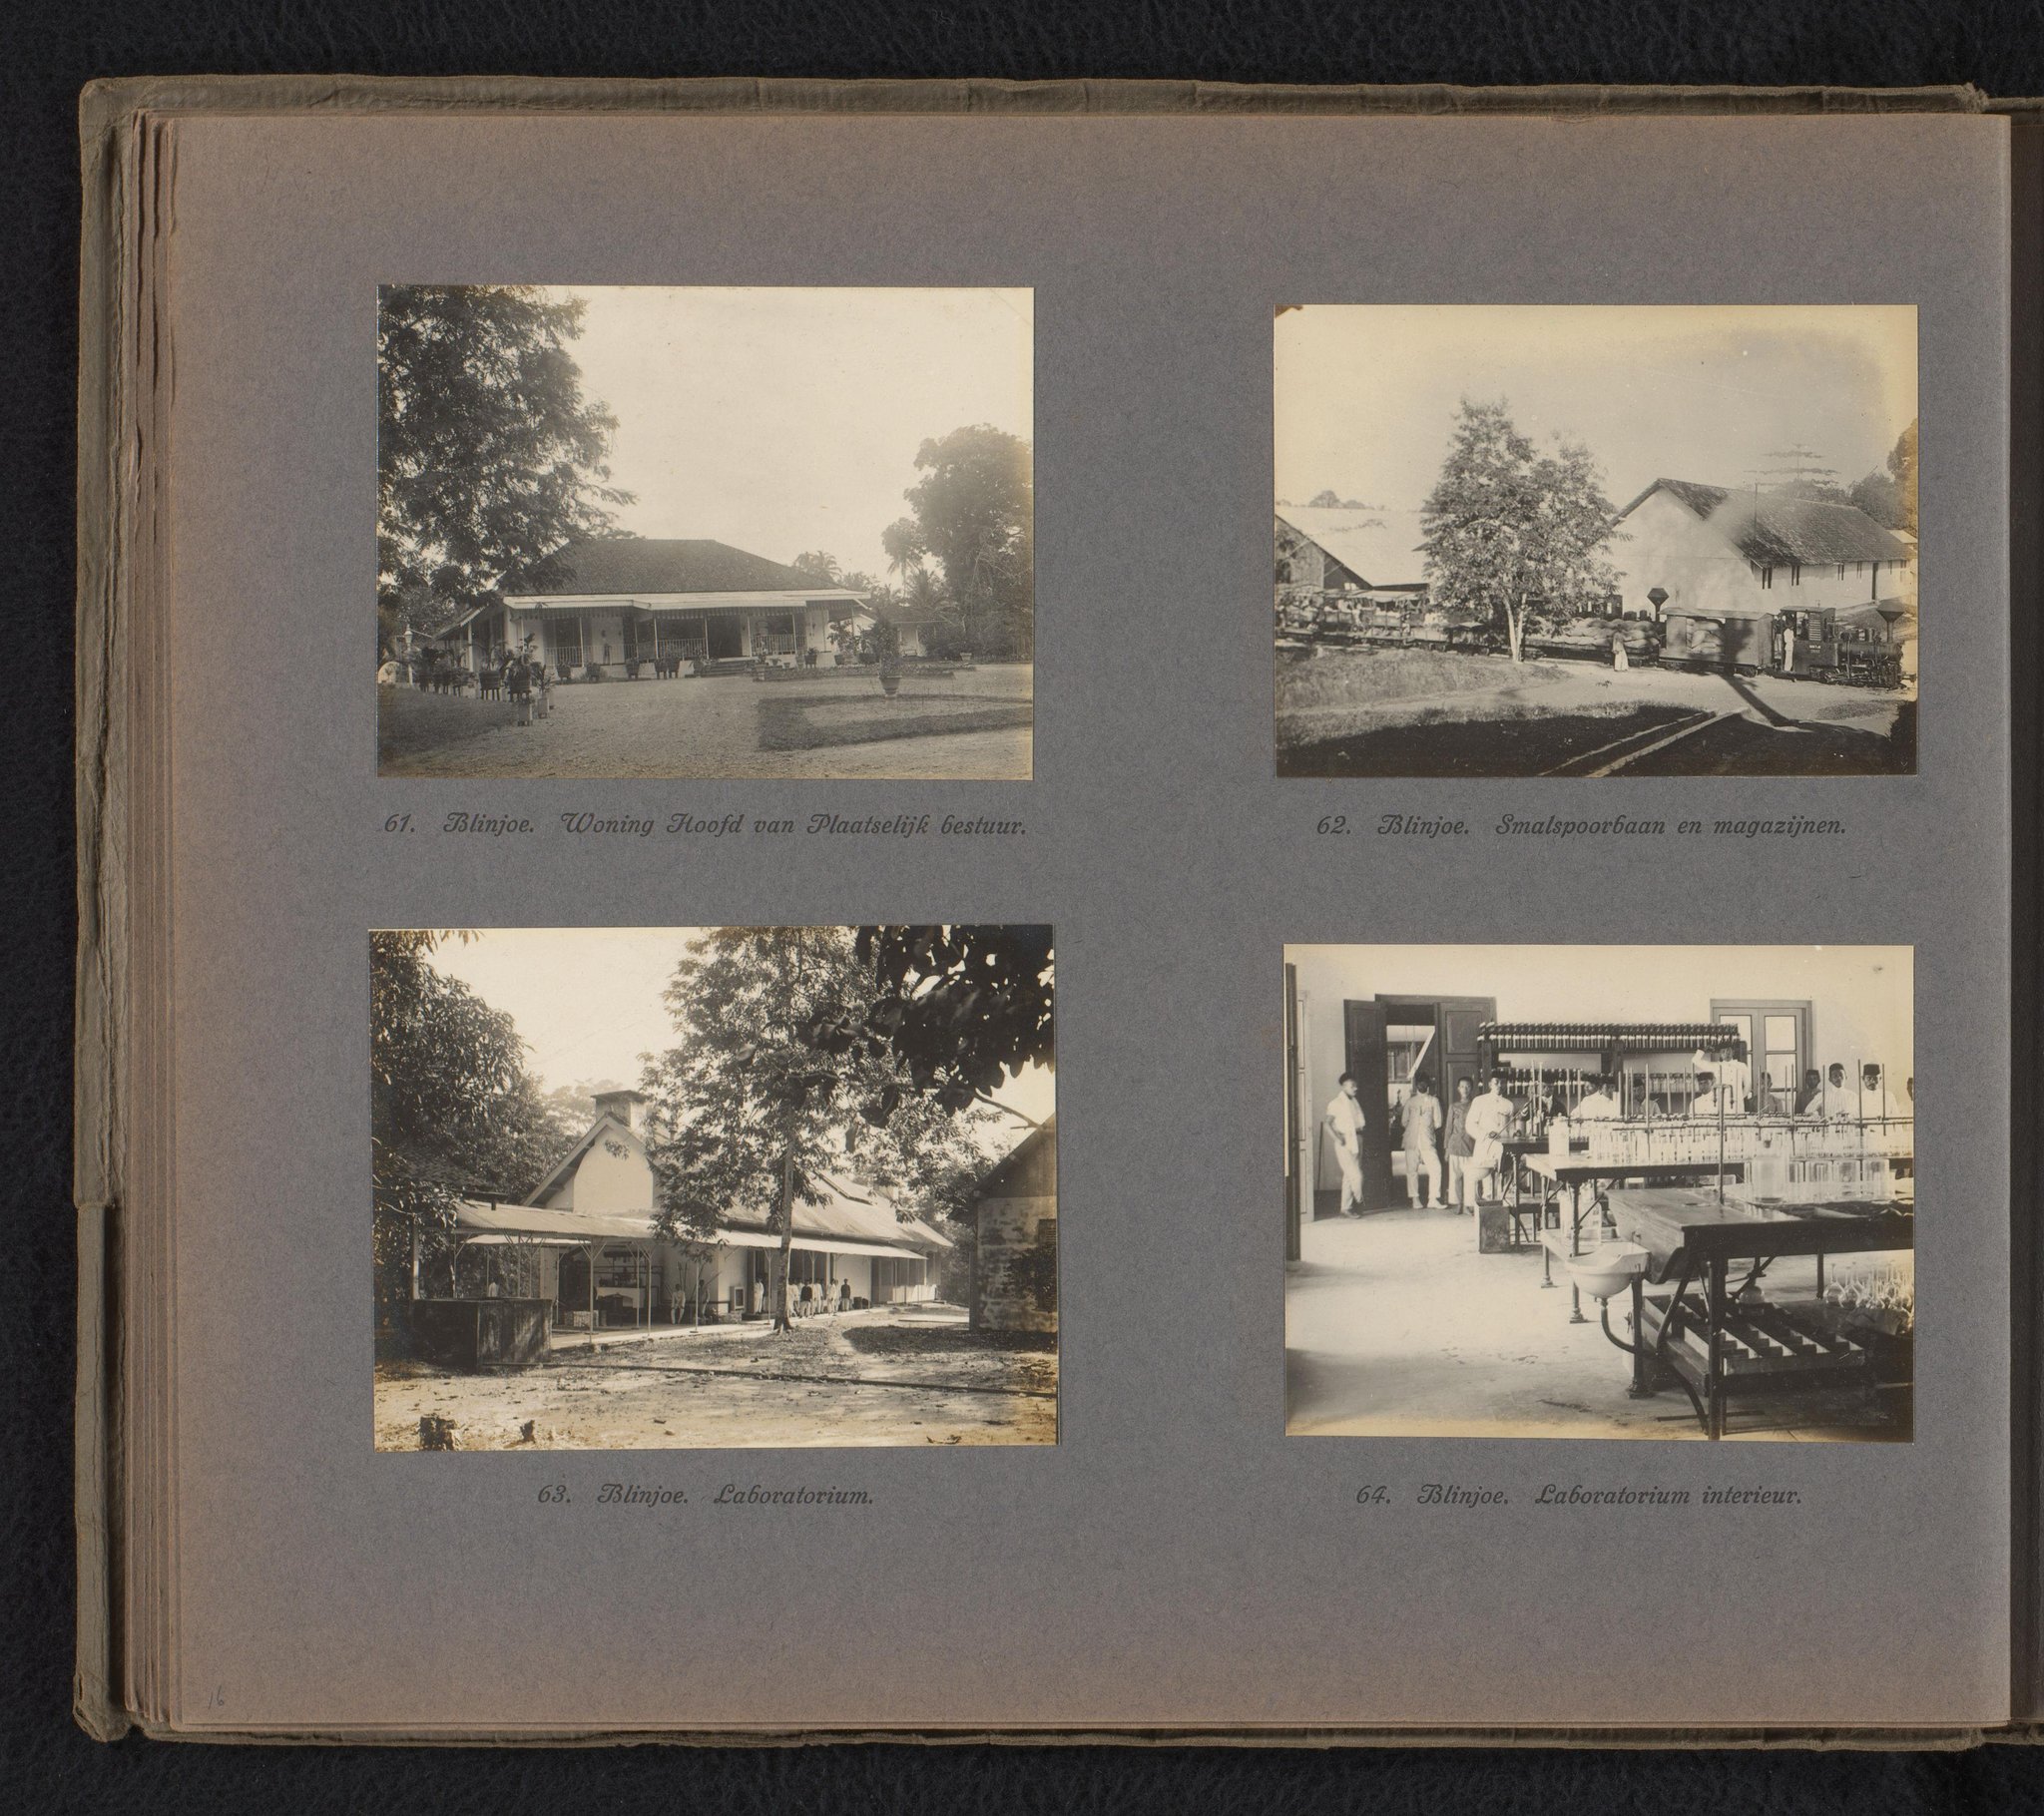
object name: photograph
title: Gebouwen te Blinjoe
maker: Anonymous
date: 1907-1919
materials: cardboard, photographic support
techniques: gelatin silver print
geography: bangka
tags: robert julius boers, colonial system, rural housing, e.g. country-house, villa, cottage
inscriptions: inscription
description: Albumblad met vier foto's genummerd 61-64 van verschillende gebouwen te Belinyu (Blinjoe) op Banka: woning, magazijnen en laboratorium van de Banka-tinwinning. Onderdeel van het Banka-Album met foto's over het eiland Banka en de tinwinning door het staatsbedrijf de Banka-tinwinning in de periode ca. 1907-1919.